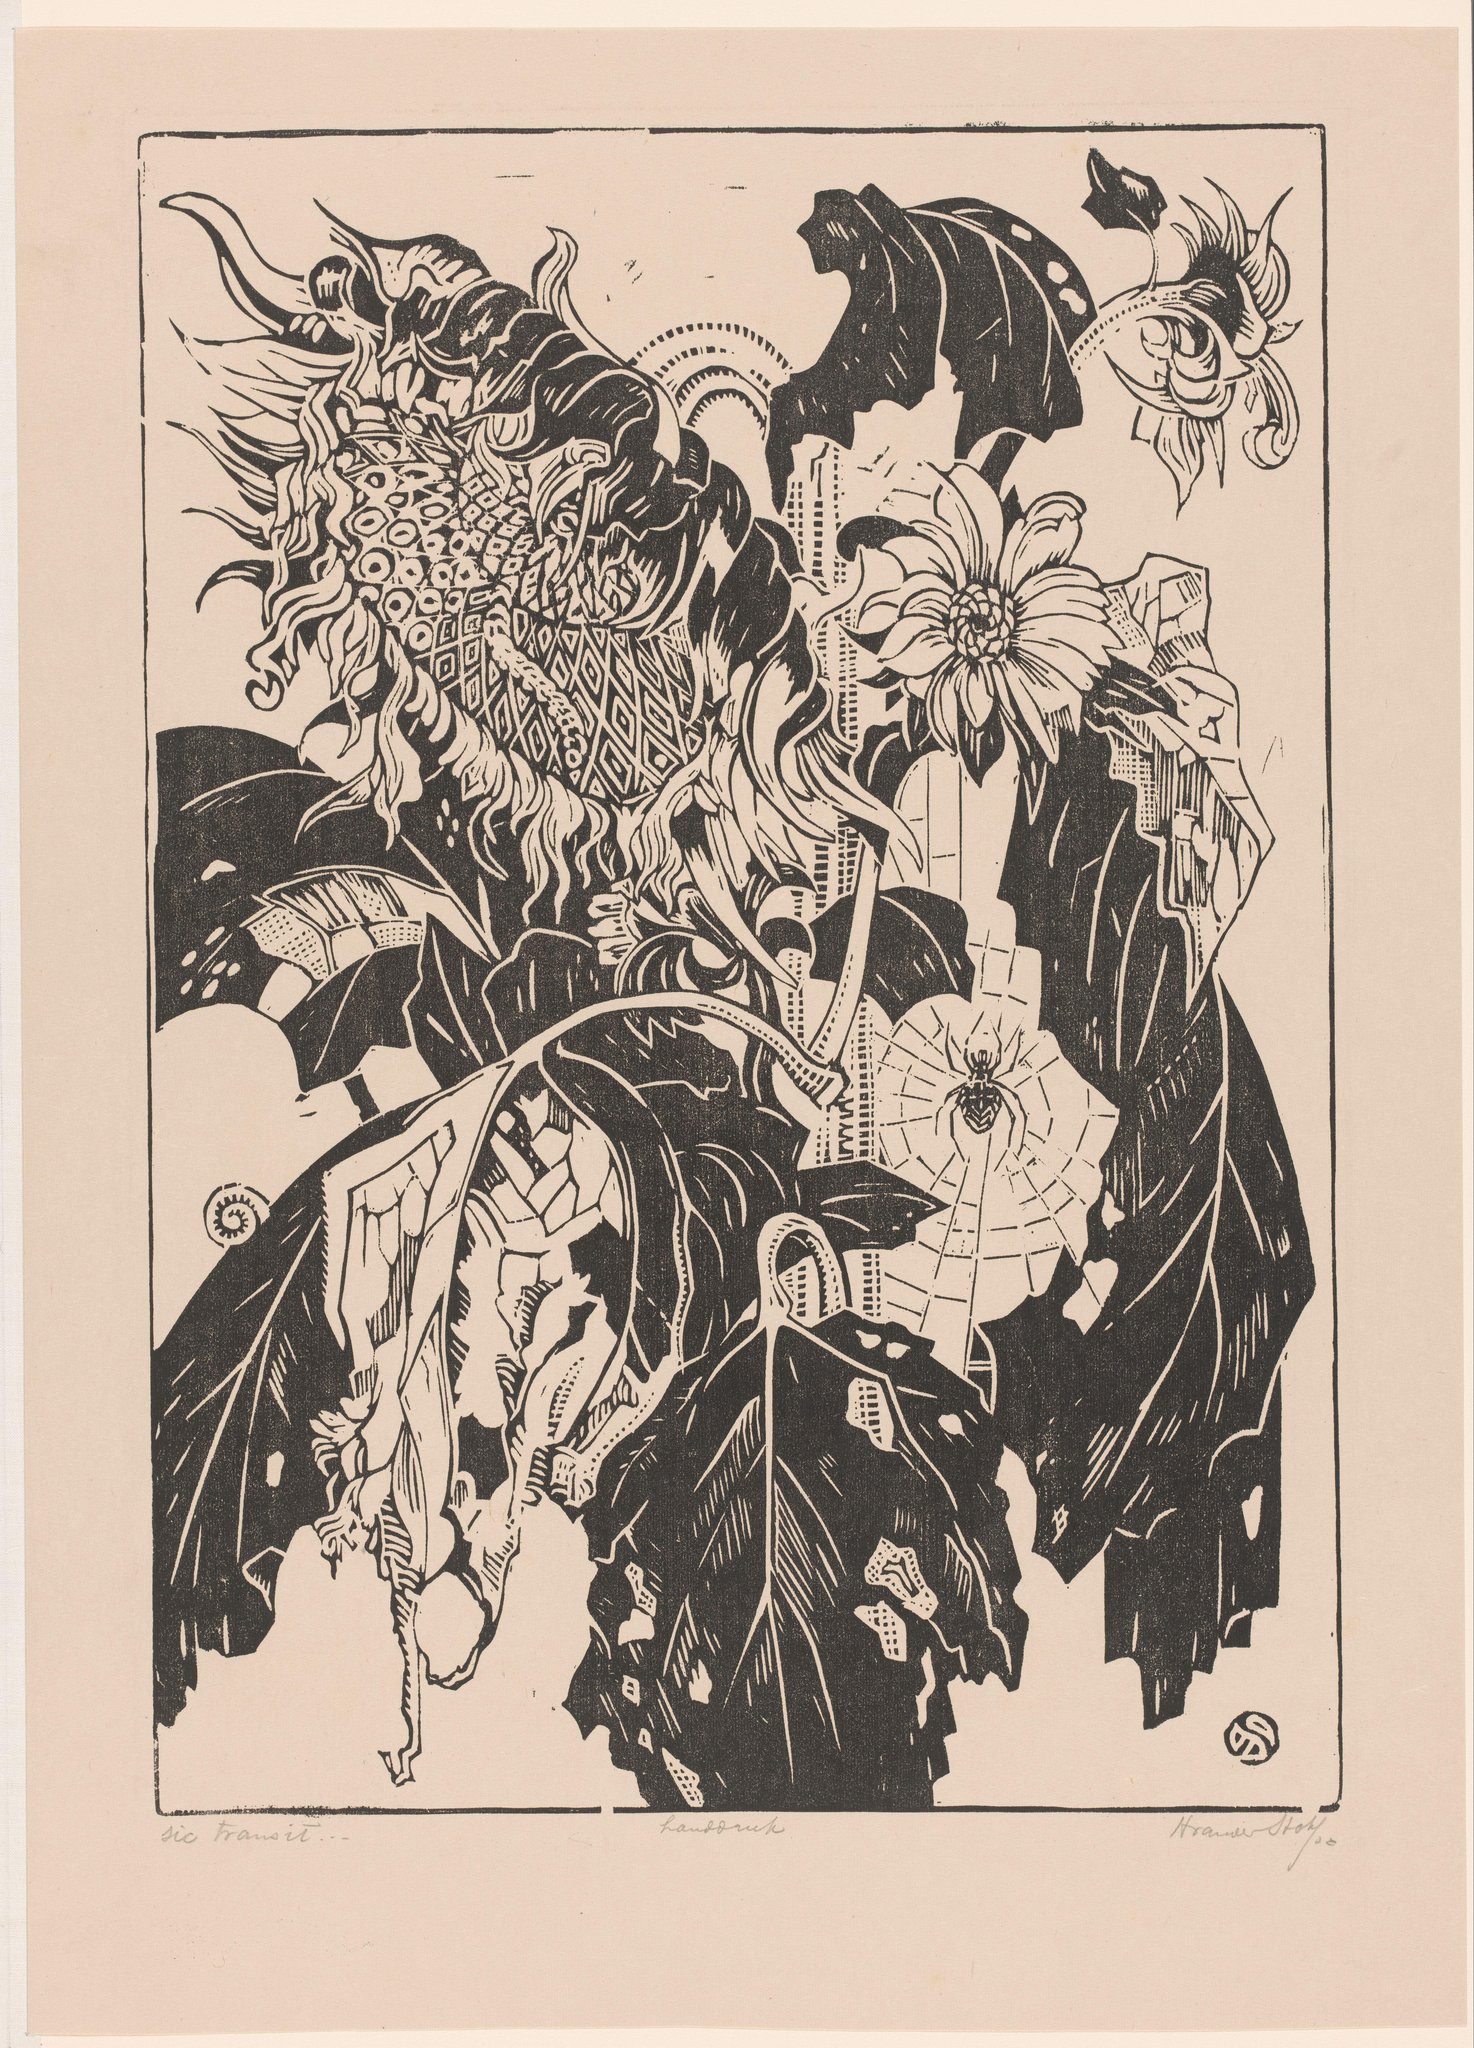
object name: print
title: Sic transit...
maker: henri van der stok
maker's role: print maker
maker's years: 1870-1946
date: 1880-1946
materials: paper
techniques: woodcut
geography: netherlands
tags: flowers: sunflower, spiders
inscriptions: collector's mark: Lugt 2228